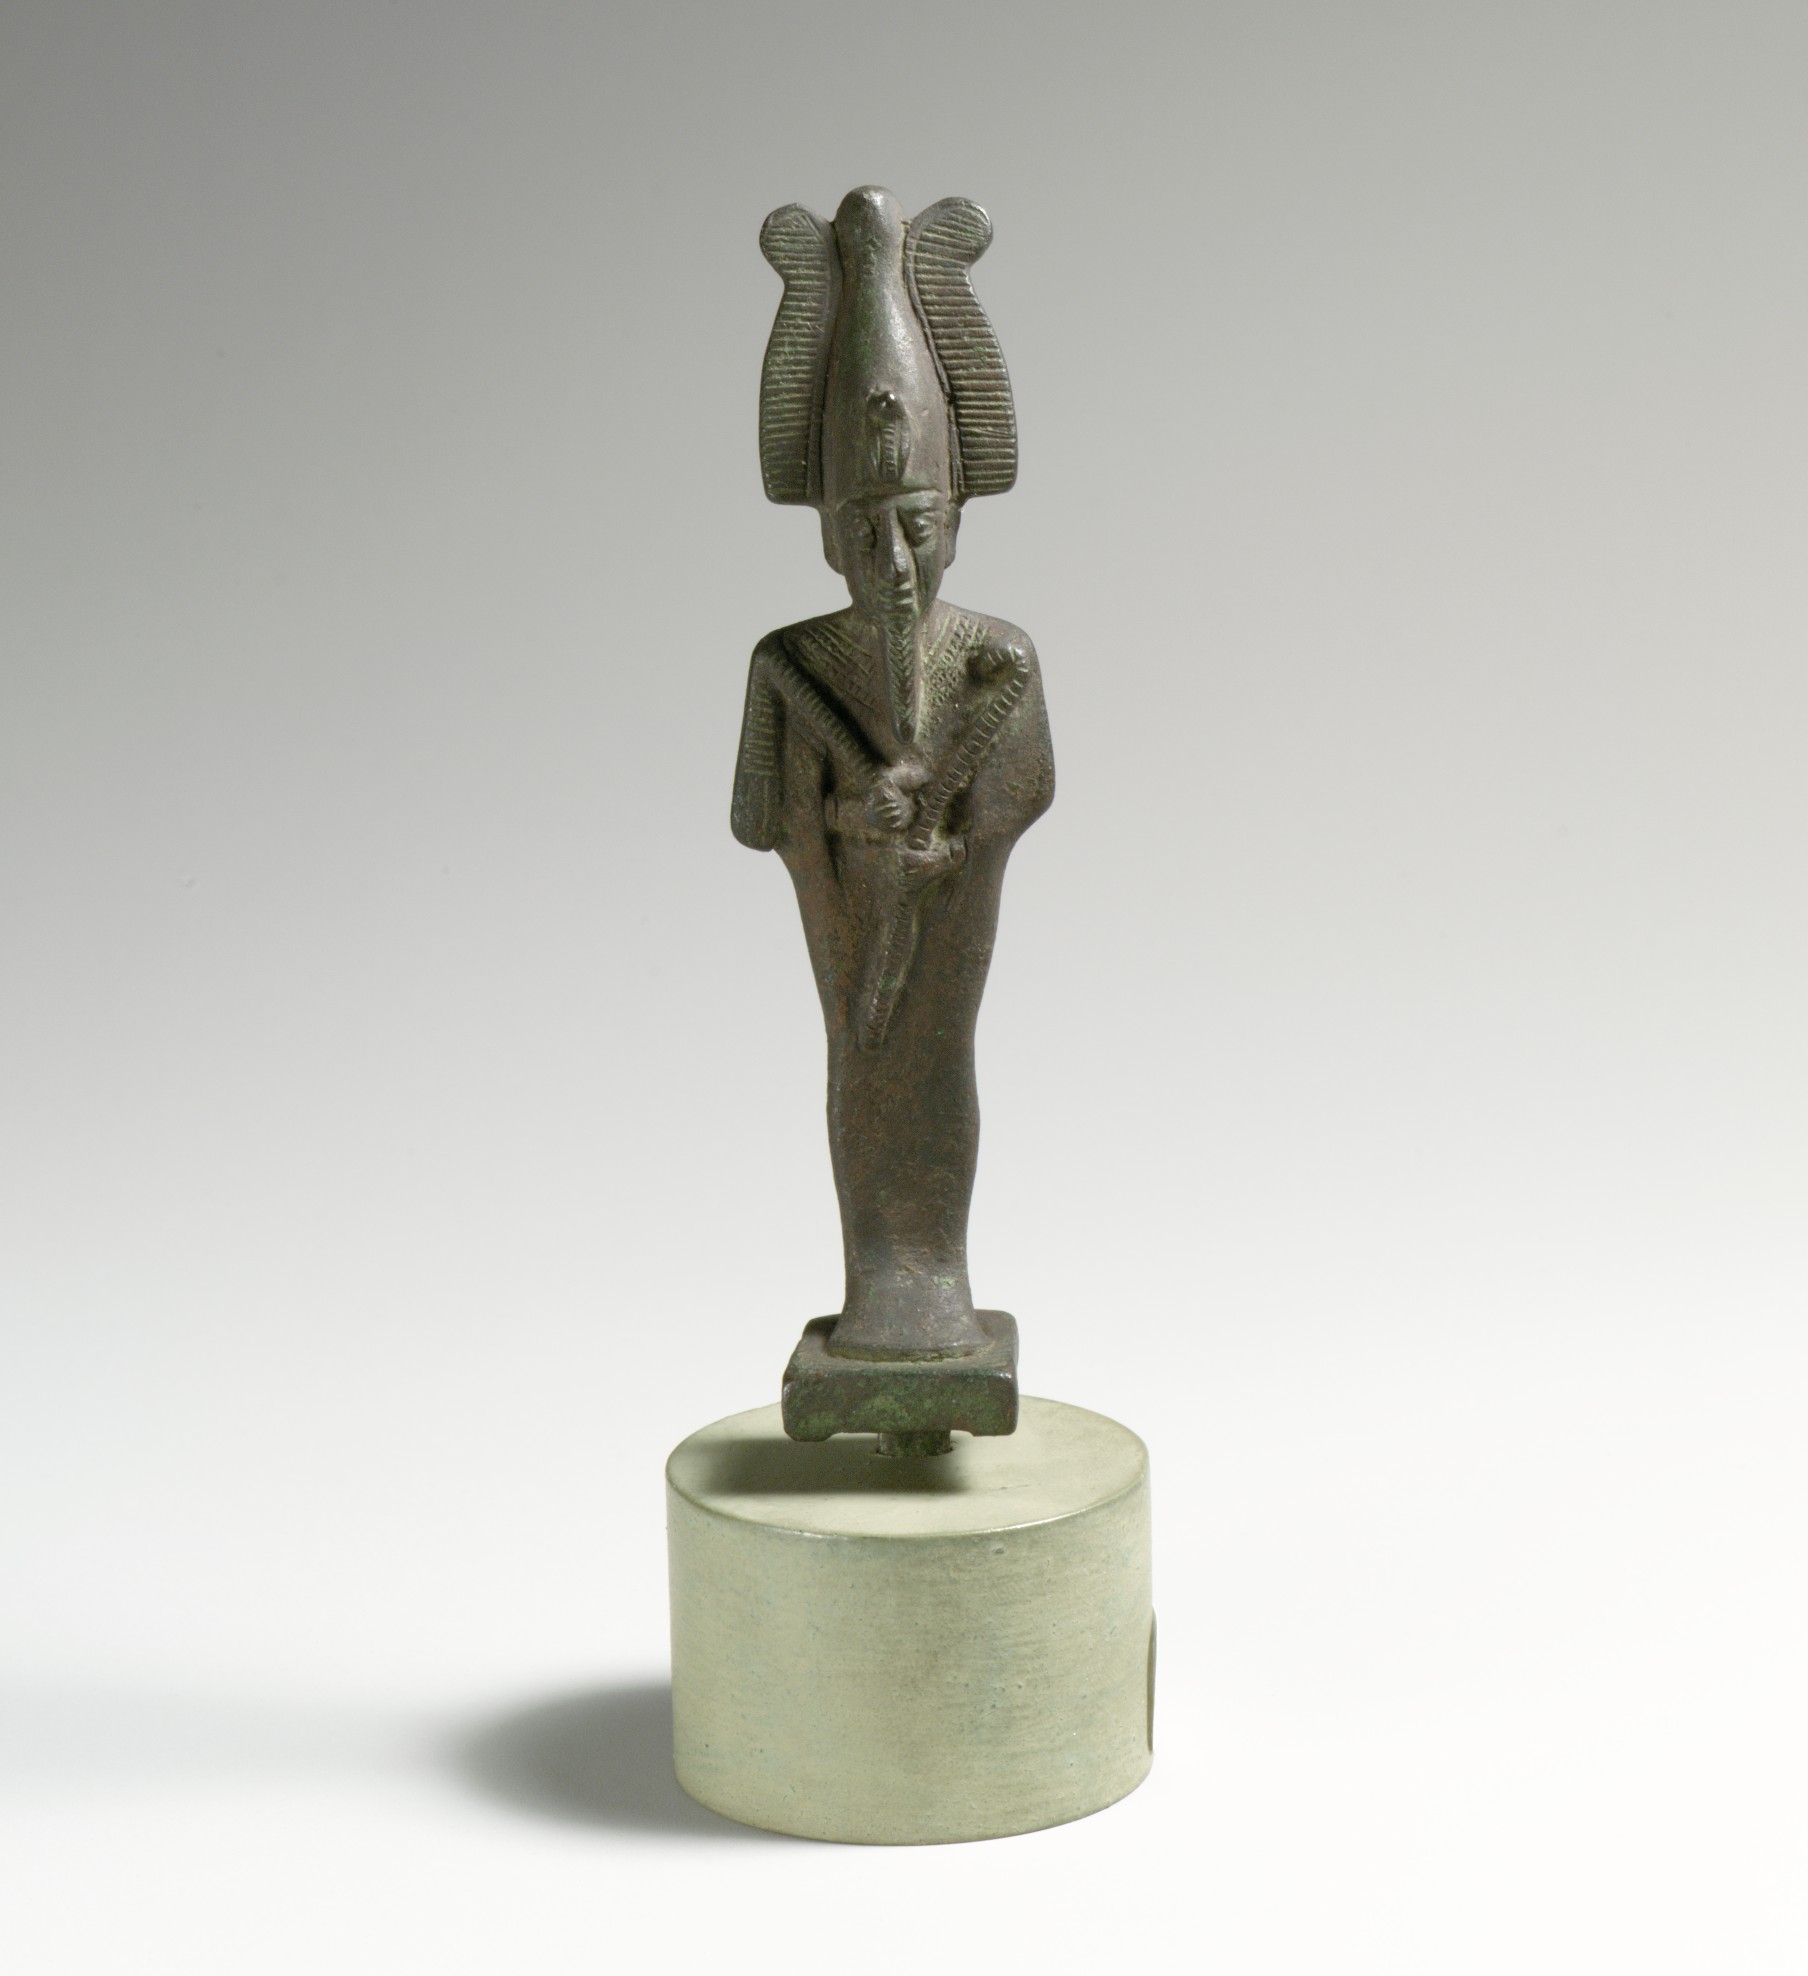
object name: statuette, osiris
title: Bronze statuette of Osiris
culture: egyptian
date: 664-631 BCE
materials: bronze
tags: osiris